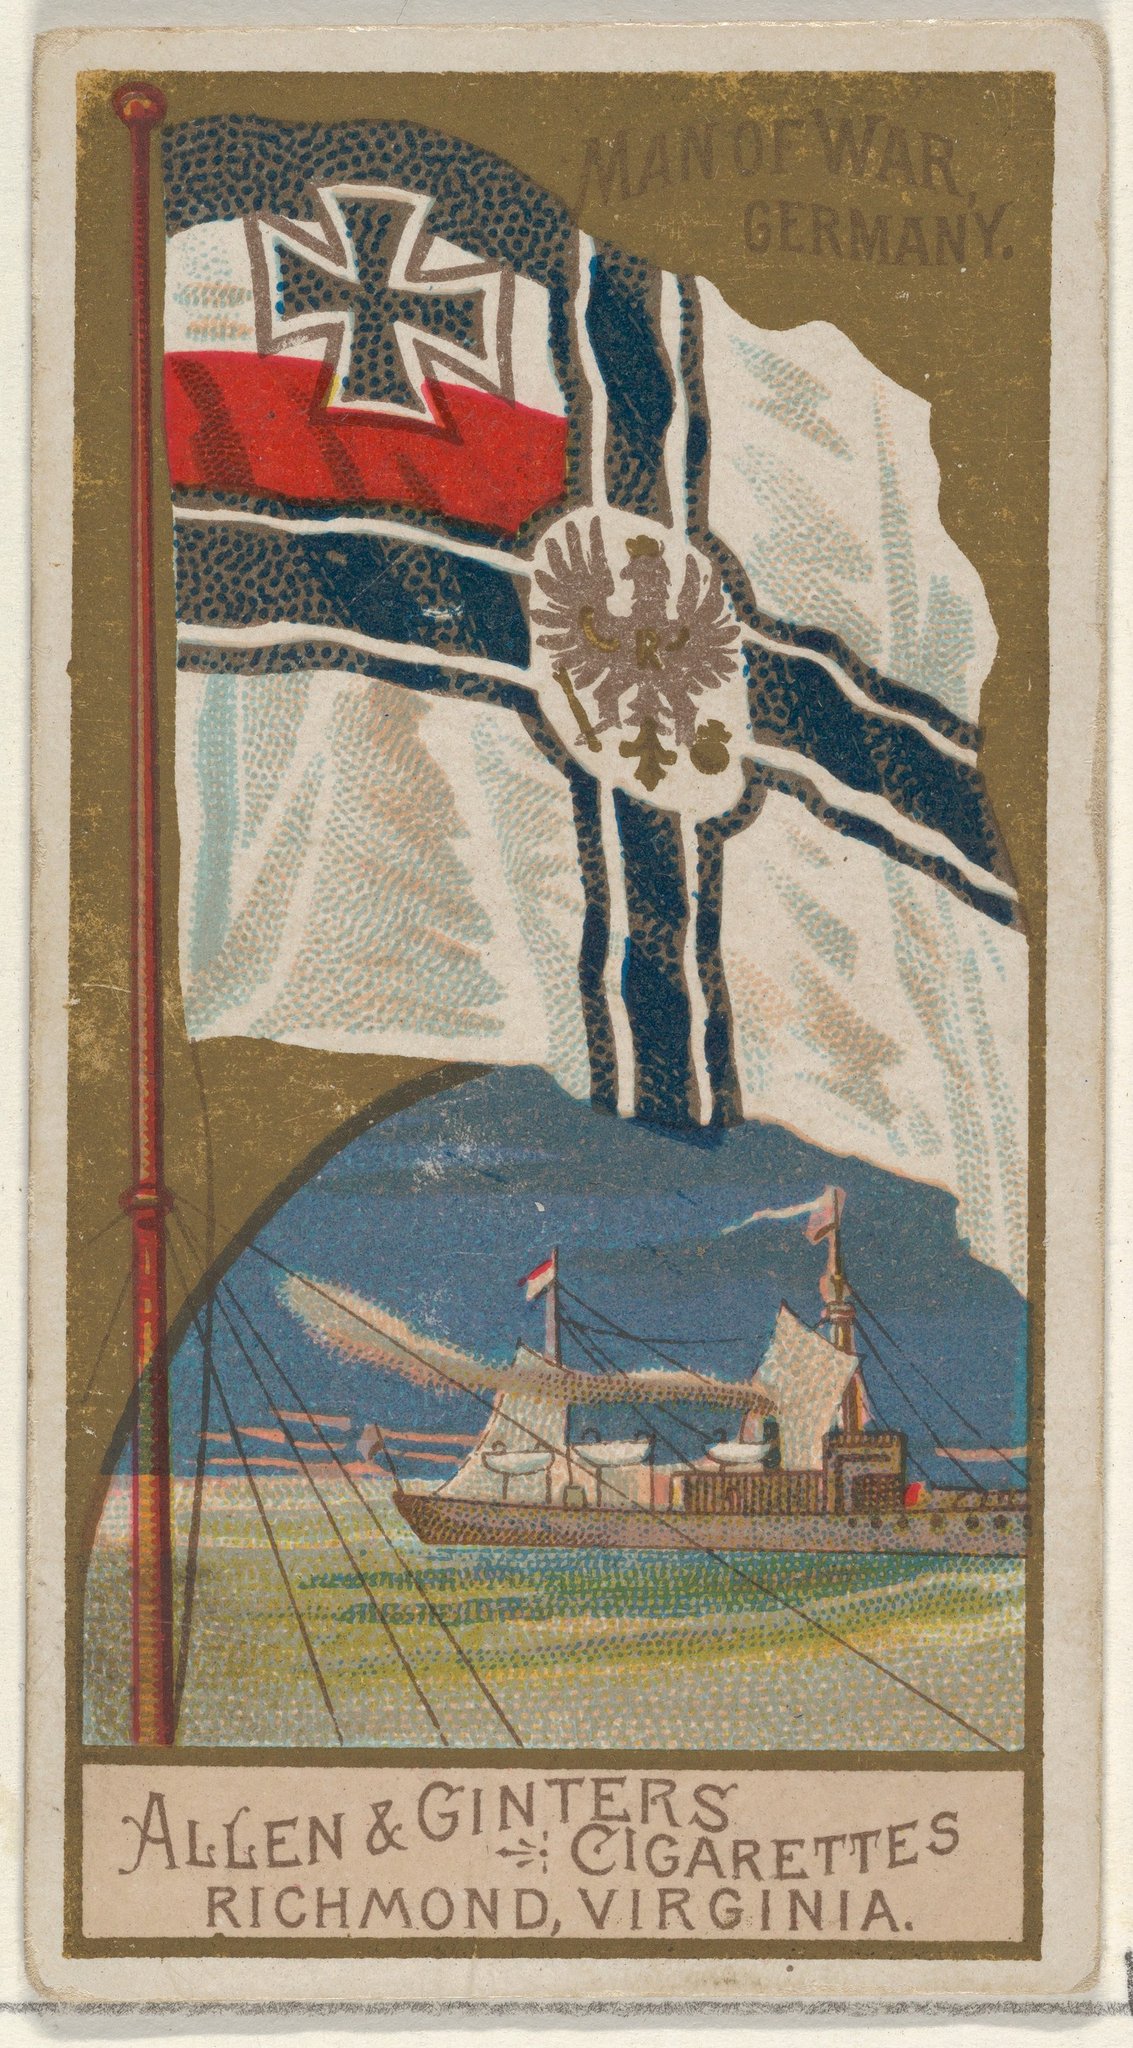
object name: print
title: Man of War, Germany, from the Naval Flags series (N17) for Allen & Ginter Cigarettes Brands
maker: allen & ginter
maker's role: publisher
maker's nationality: american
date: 1888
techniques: color lithograph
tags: flags